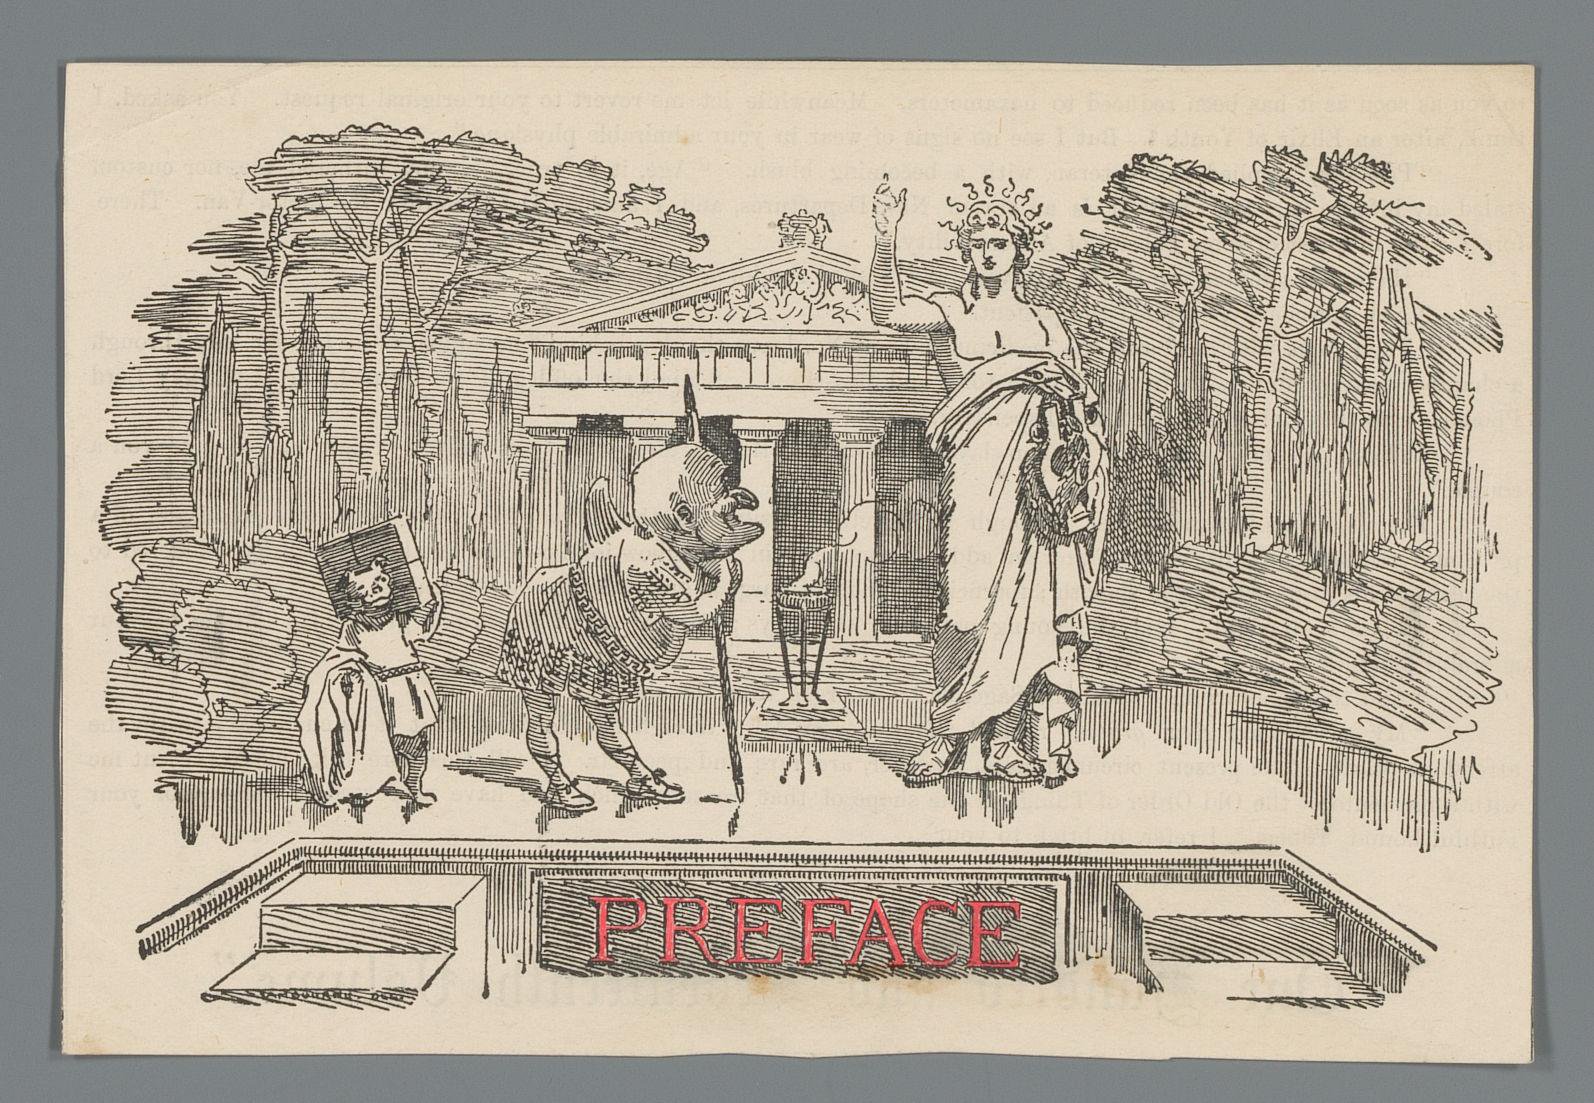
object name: cartoon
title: Vignet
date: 1899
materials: paper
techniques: line block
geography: england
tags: political caricatures and satires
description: Vignet met Punch voor een Griekse tempel, bij het voorwoord bij vol. 117 van het Engelse satirische tijdschrift Punch, 1899.